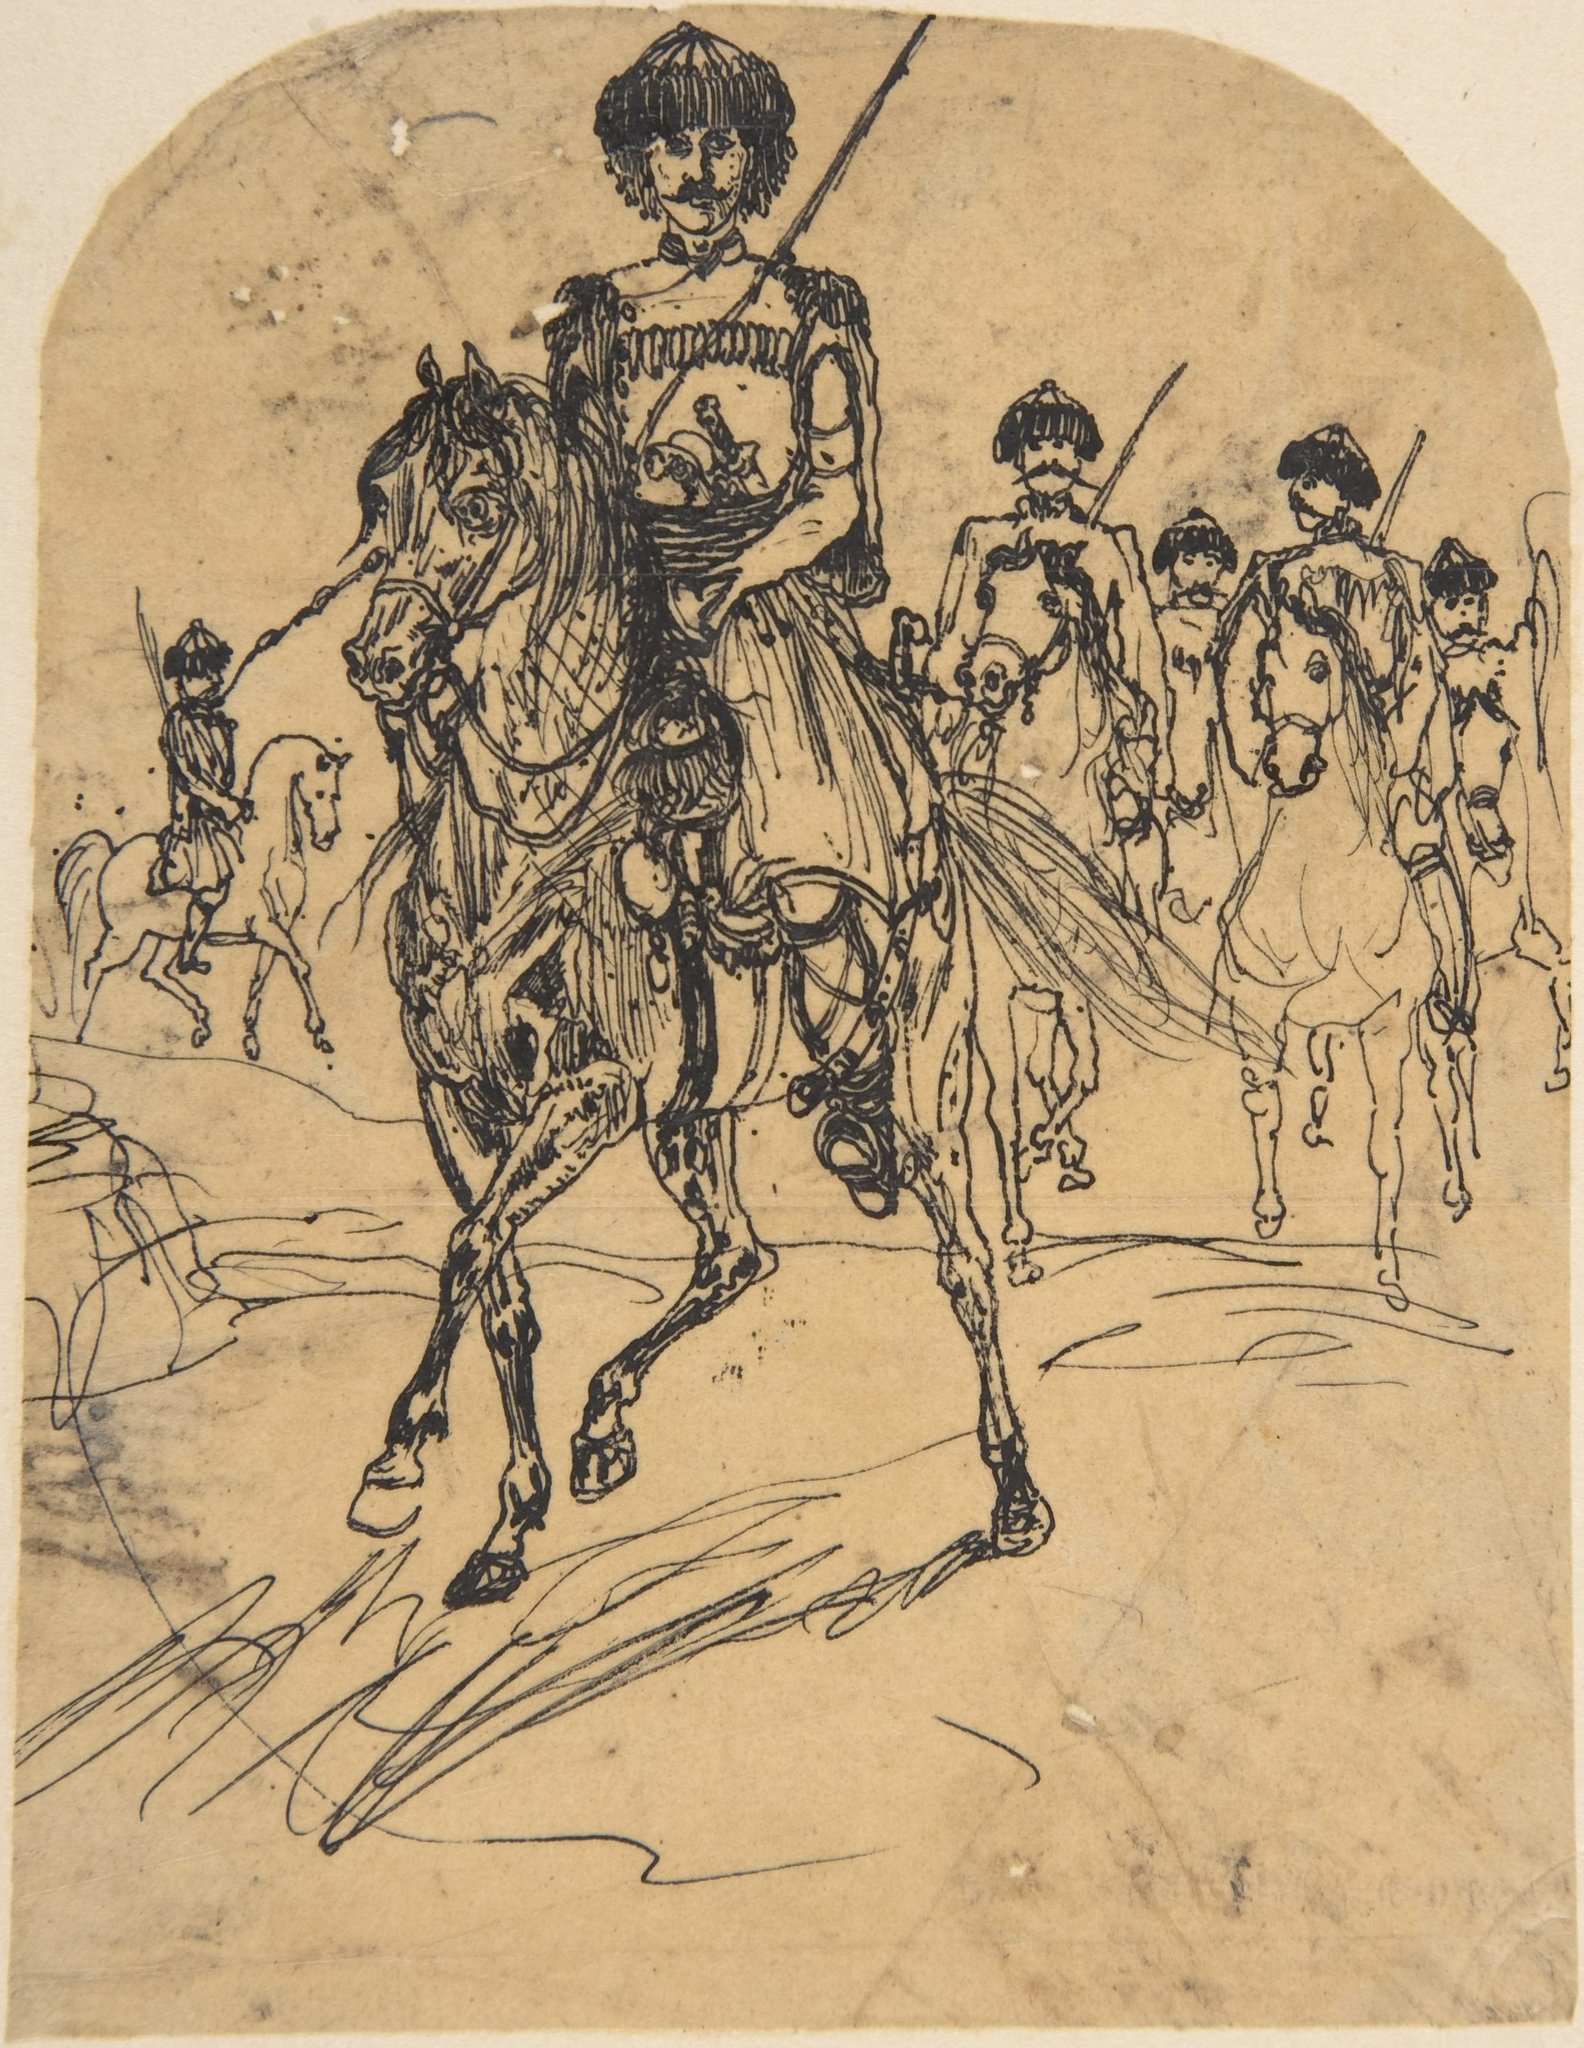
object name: drawing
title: Muscovite Rider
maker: rodolphe bresdin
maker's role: artist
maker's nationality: french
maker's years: 1822-1885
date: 1822-1885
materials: ink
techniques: pen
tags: men,horses